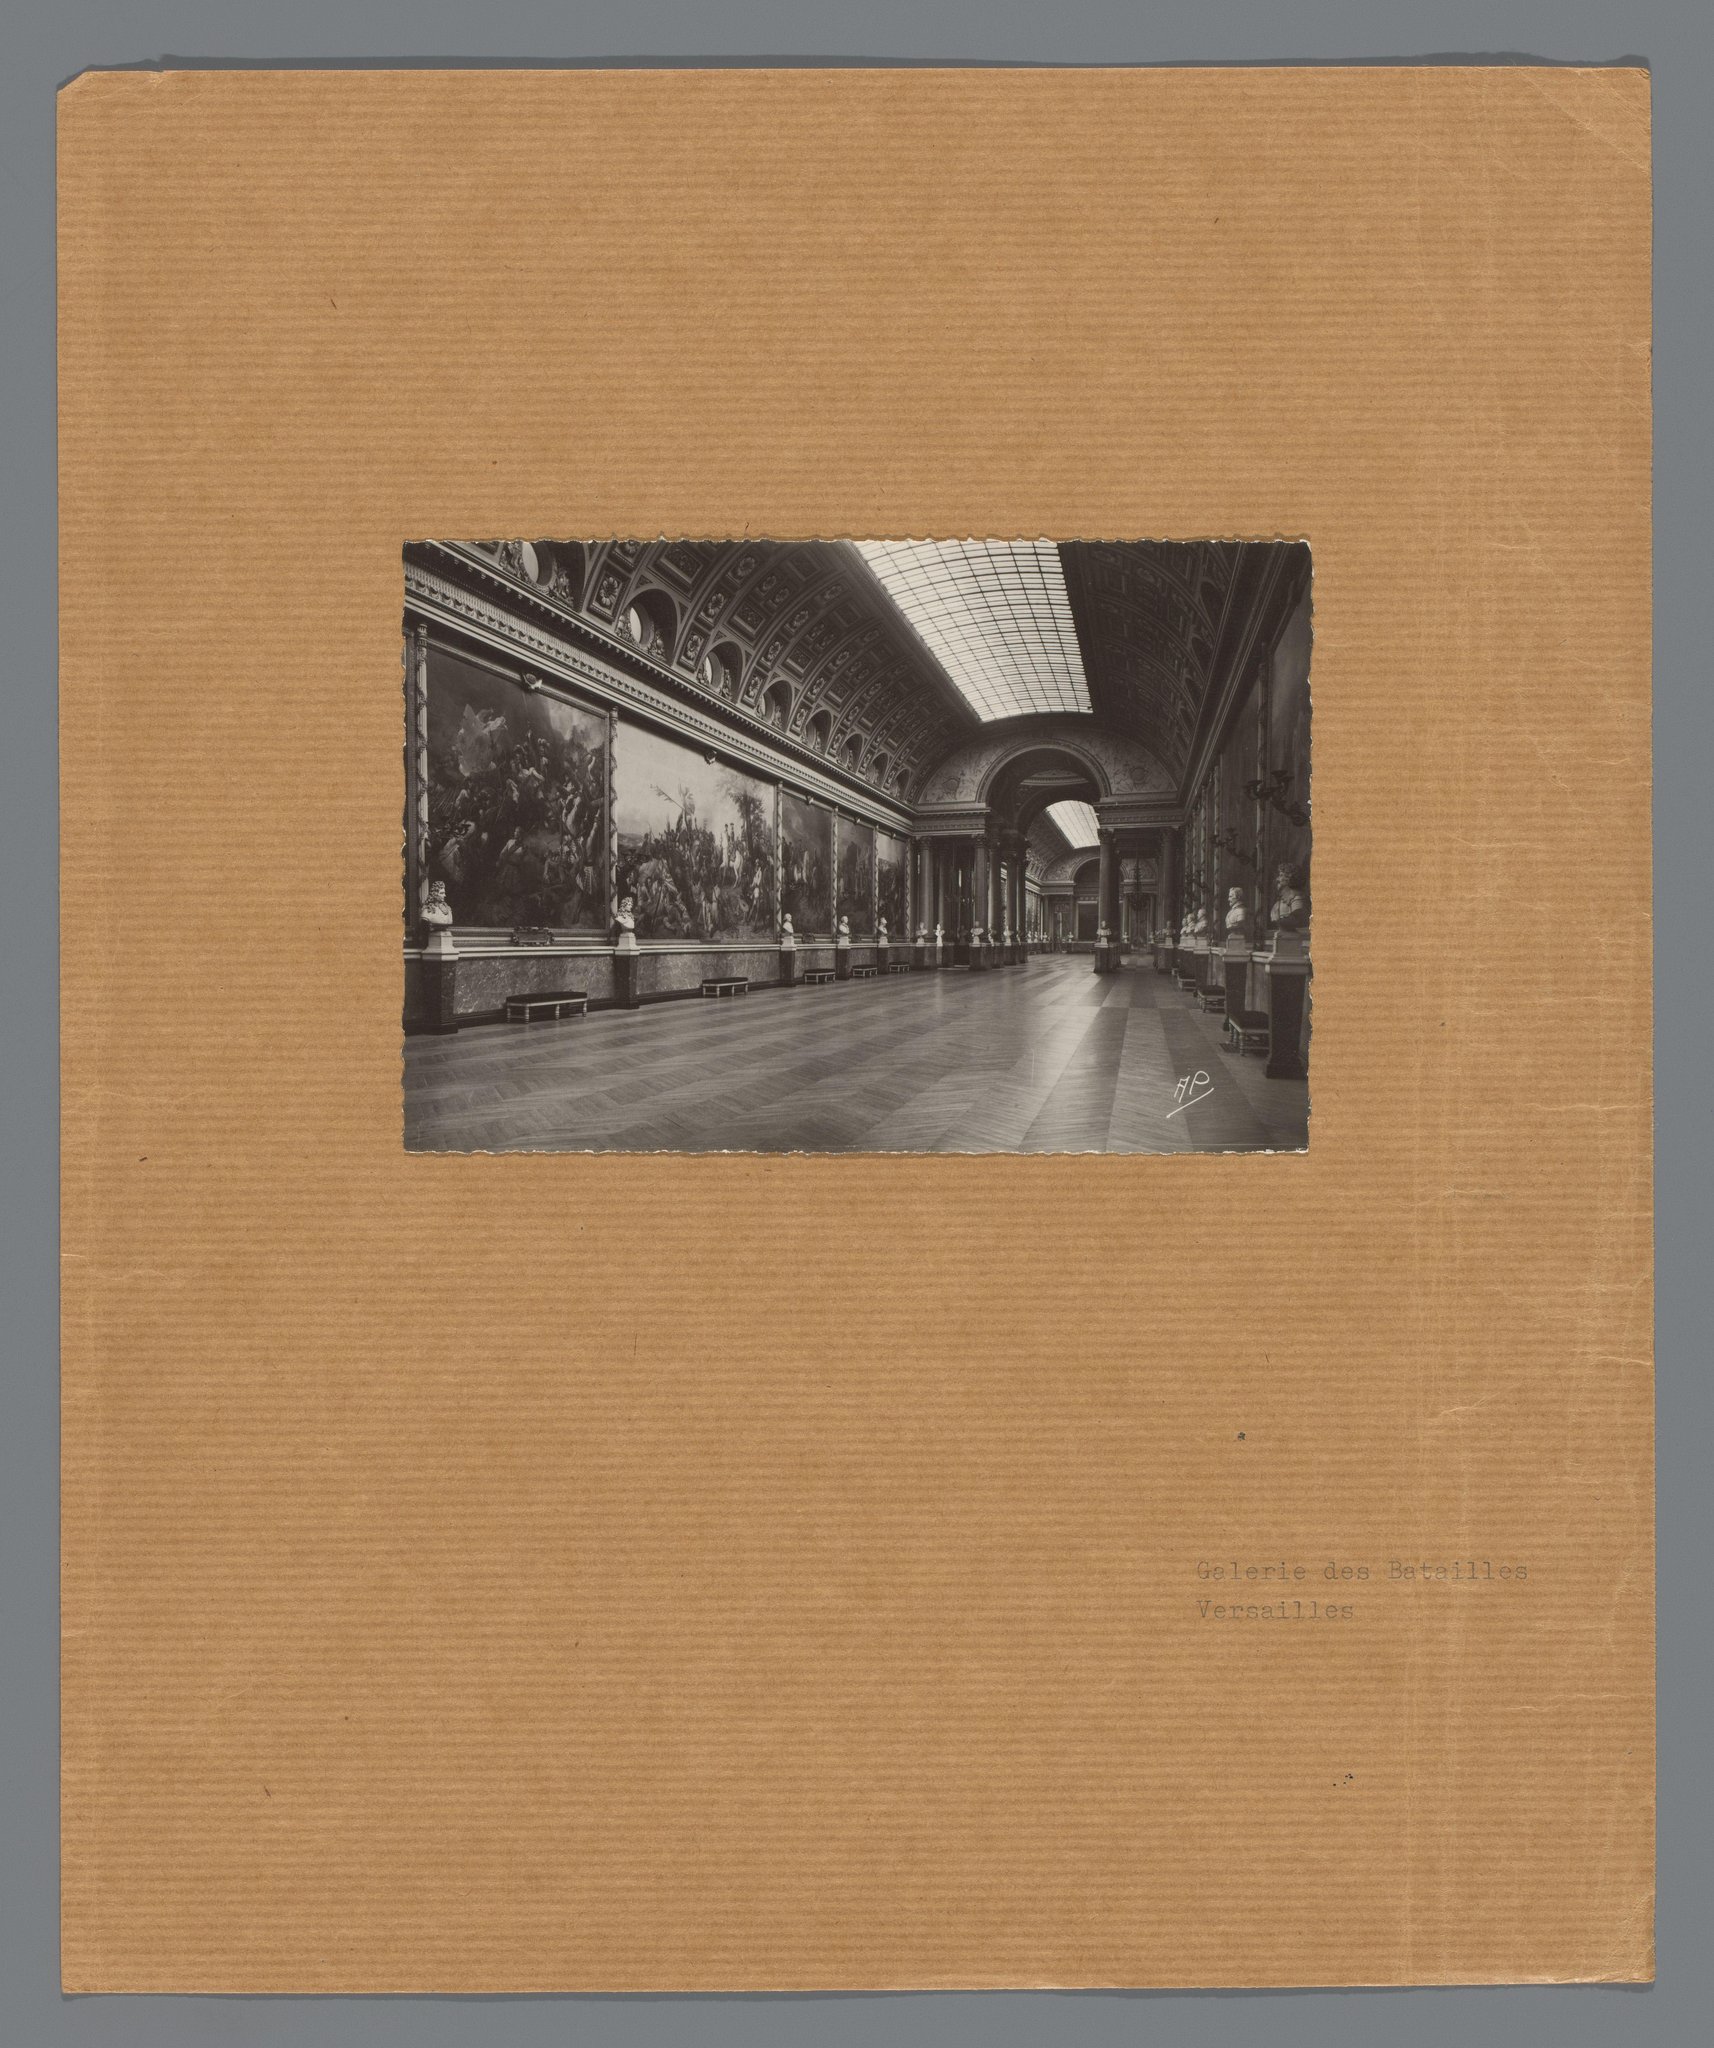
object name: photograph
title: Versailles. Galerie des Batalles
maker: Anonymous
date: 1880-1930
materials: photographic support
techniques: gelatin silver print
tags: kasteel van versailles